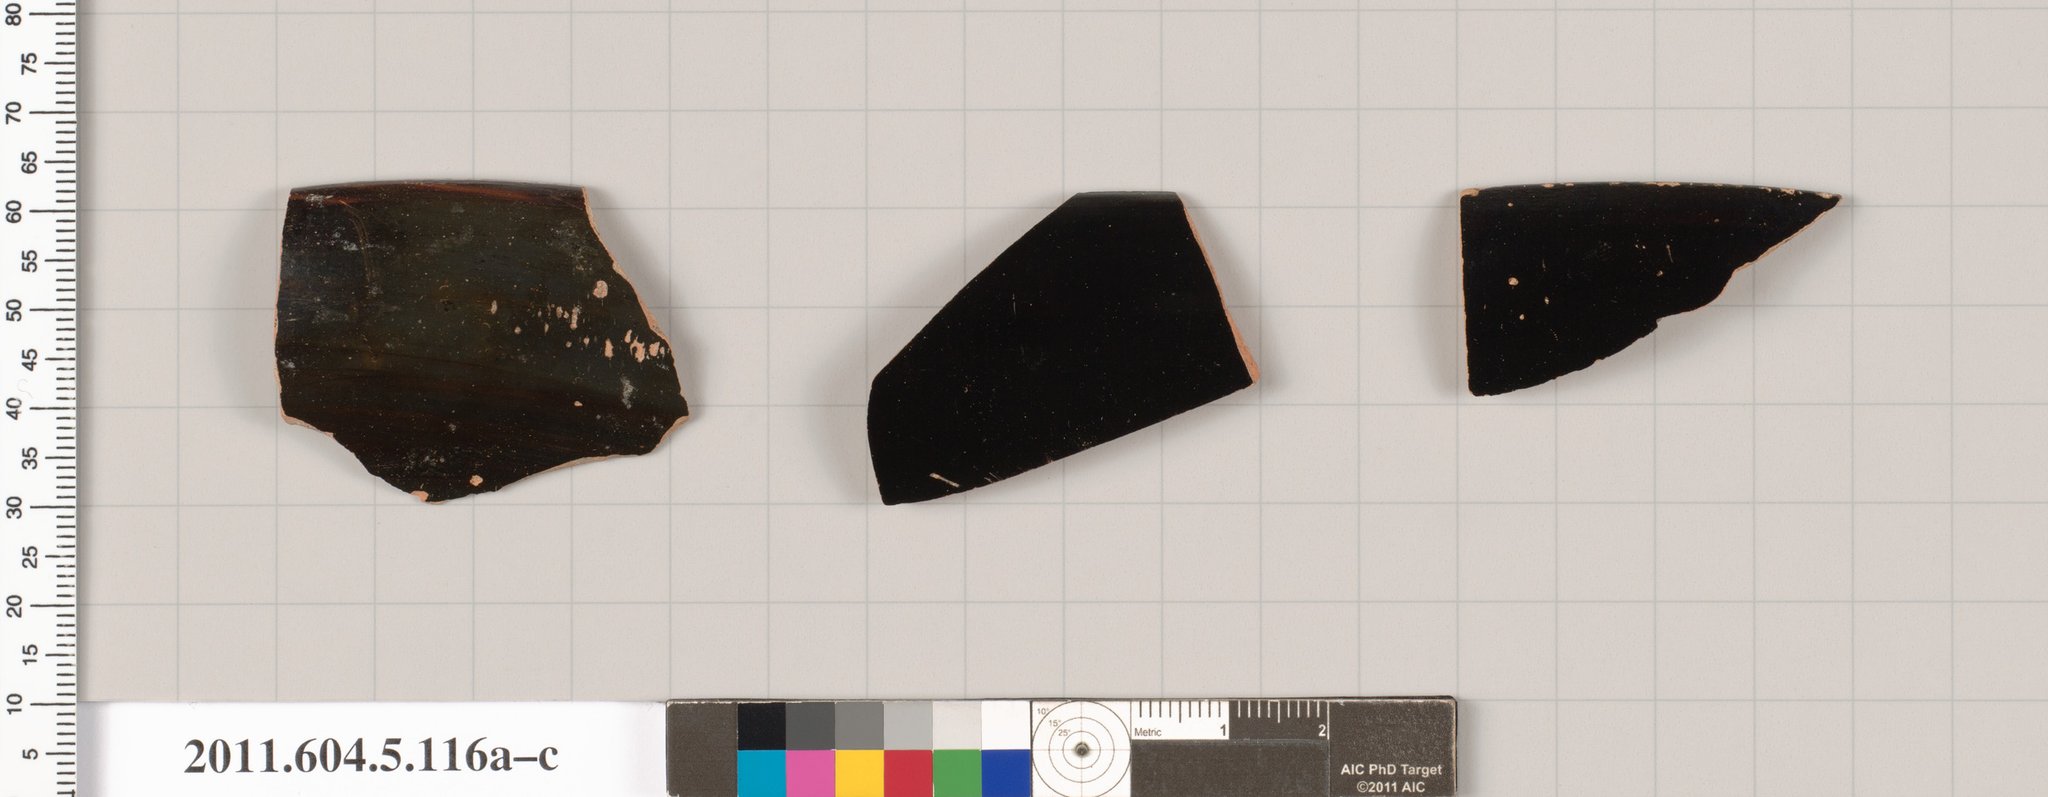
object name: kylix fragment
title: Terracotta rim fragments of stemless kylikes (drinking cups)?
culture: greek, attic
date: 470-450 BCE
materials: terracotta